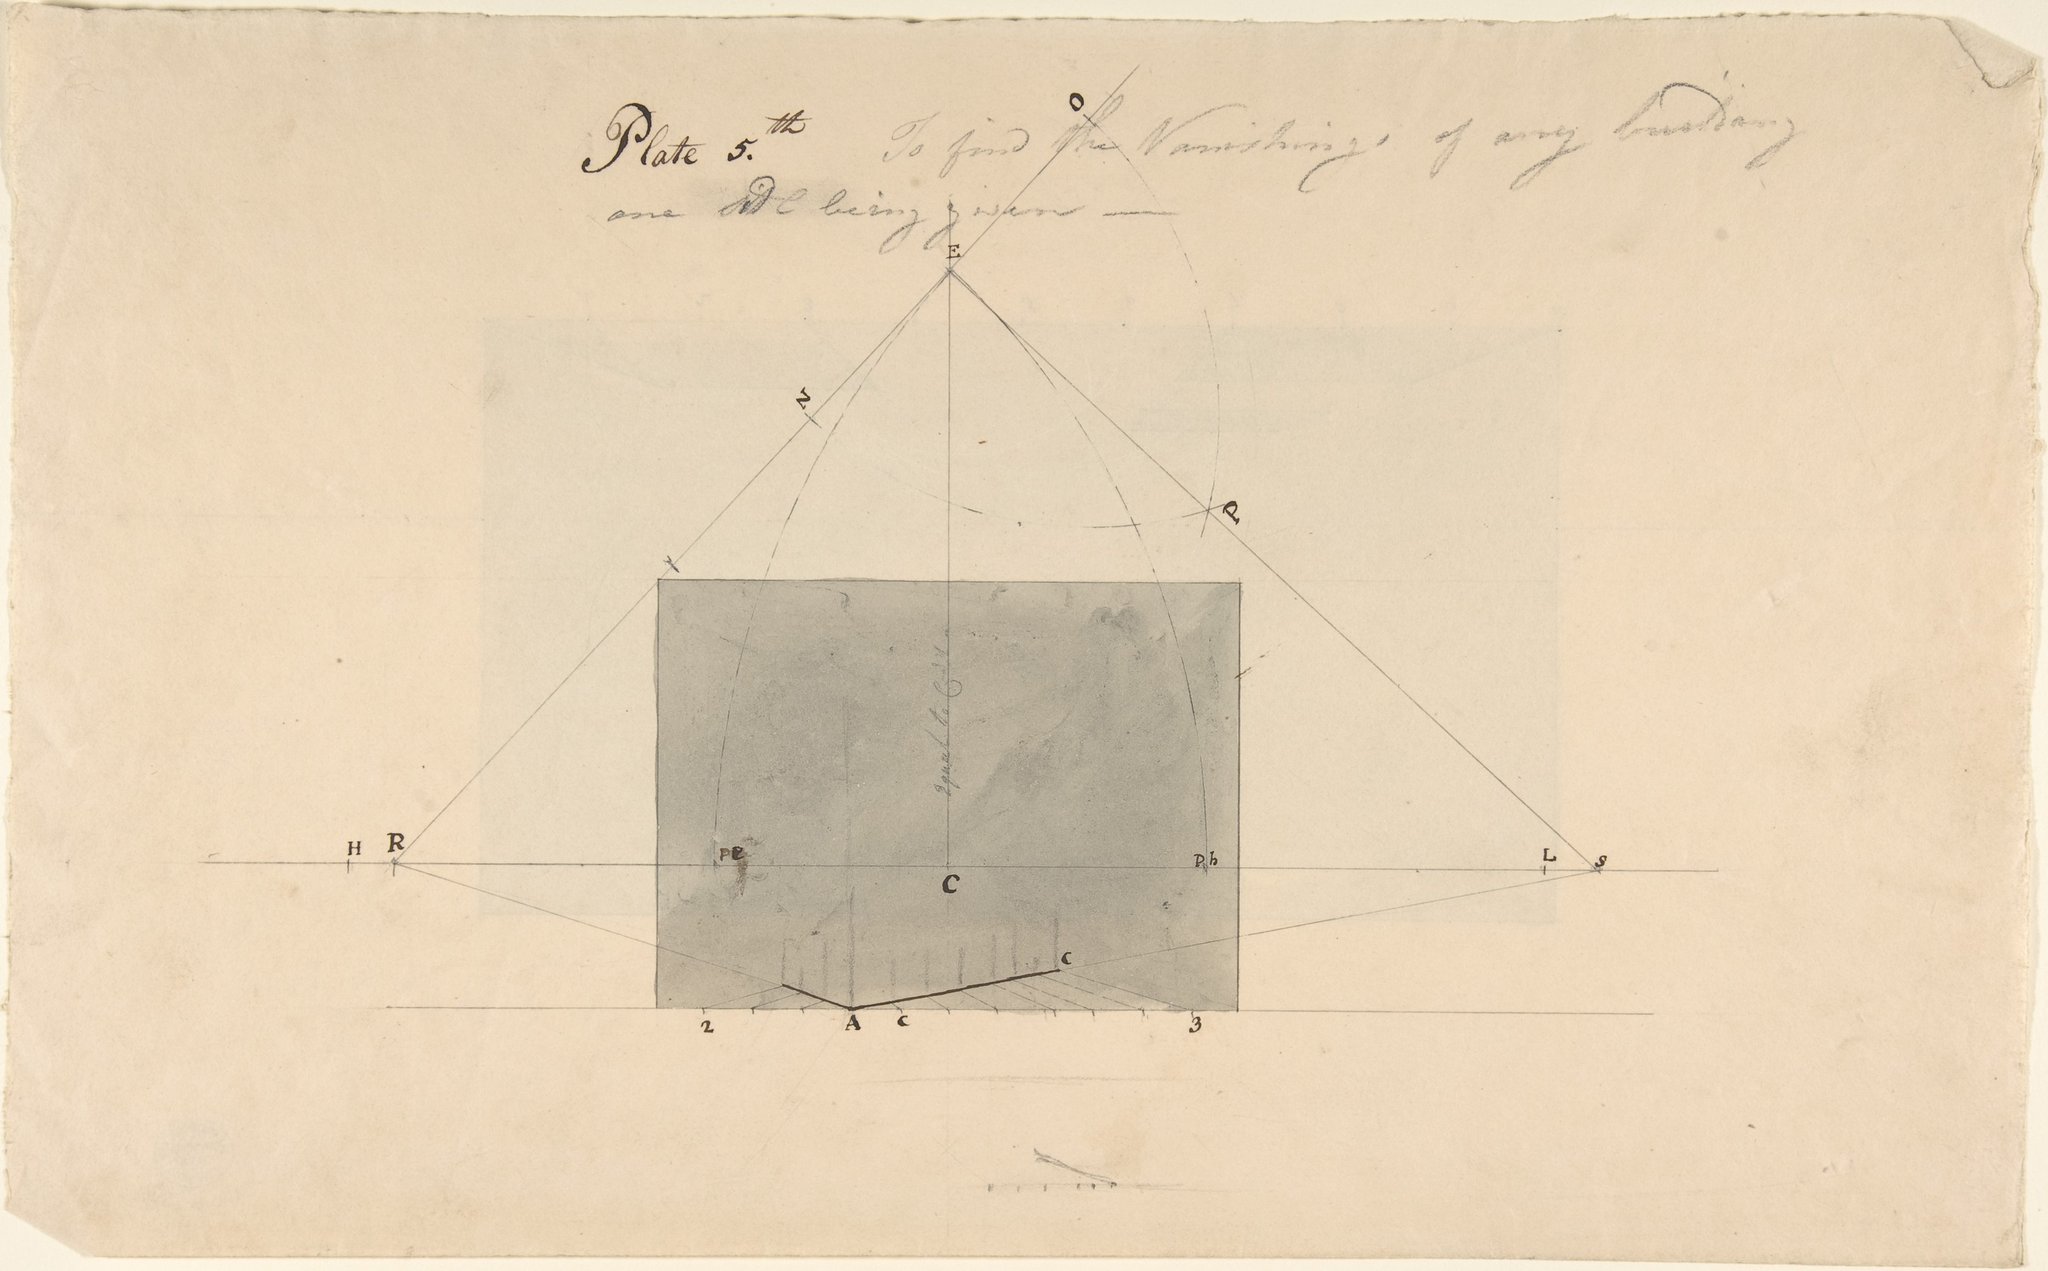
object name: drawing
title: To Find the Vanishing of Any Building, one side being given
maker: anonymous, british, 18th century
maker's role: artist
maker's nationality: british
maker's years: 1700-1800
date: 1701-1800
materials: graphite, ink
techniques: brush, pen, wash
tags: architecture